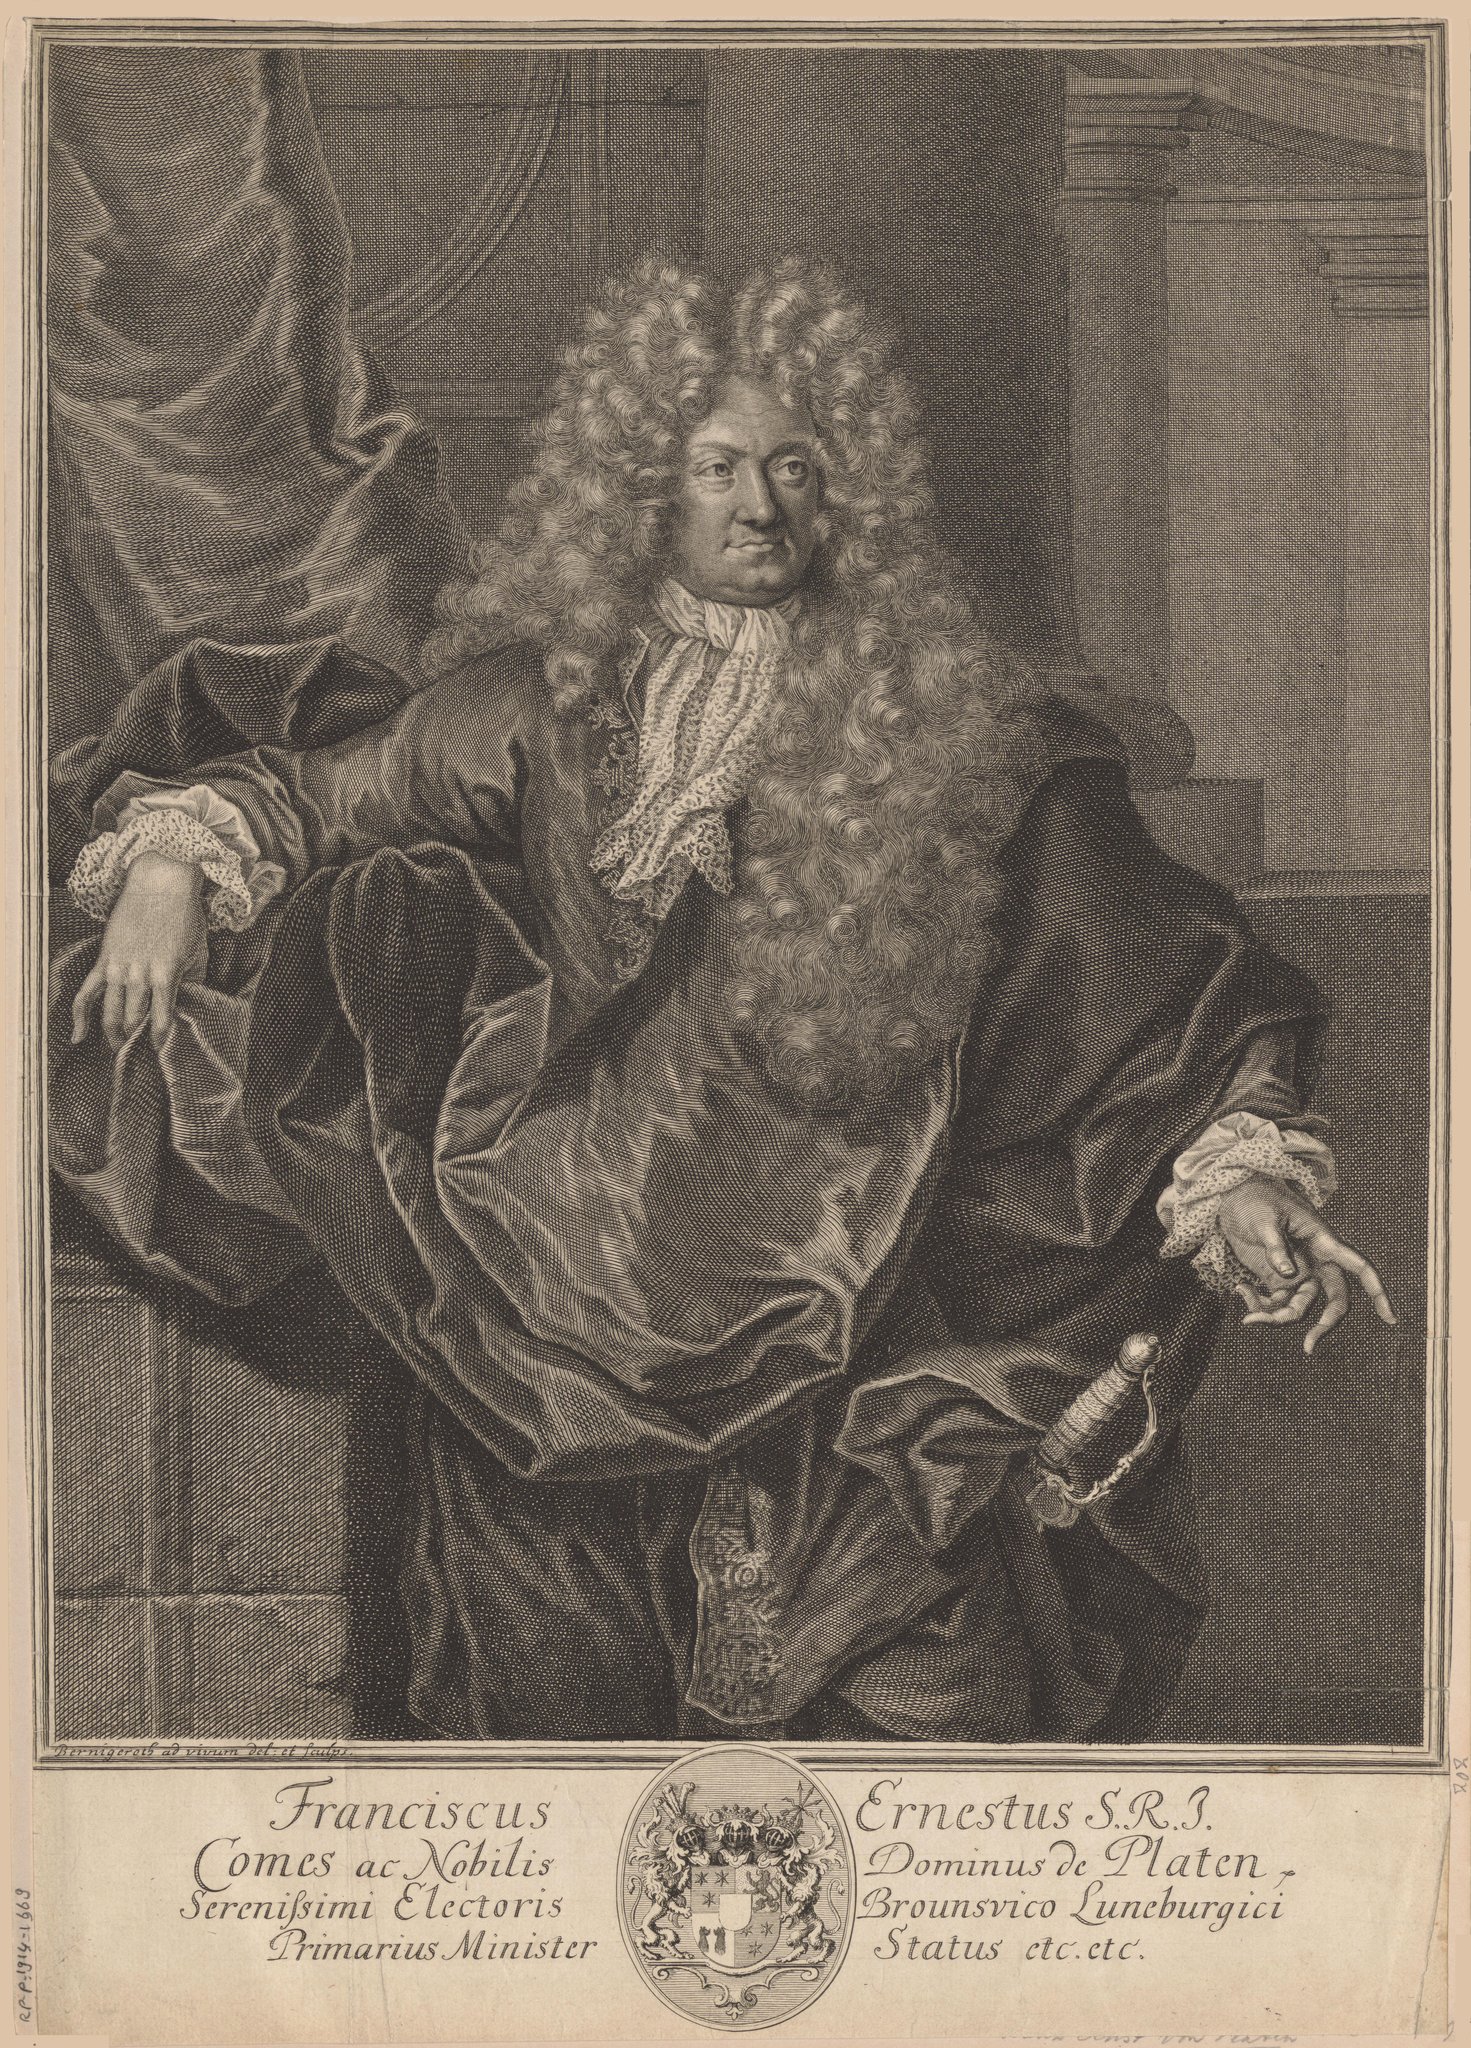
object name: print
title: Portret van Franz Ernst, Reichsgraf von Platen-Hallermund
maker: johann martin bernigeroth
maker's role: print maker, publisher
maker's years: 1713-1767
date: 1723-1767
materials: paper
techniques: engraving, etching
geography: leipzig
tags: adult man, historical persons, armorial bearing, heraldry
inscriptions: collector's mark: Lugt 2228